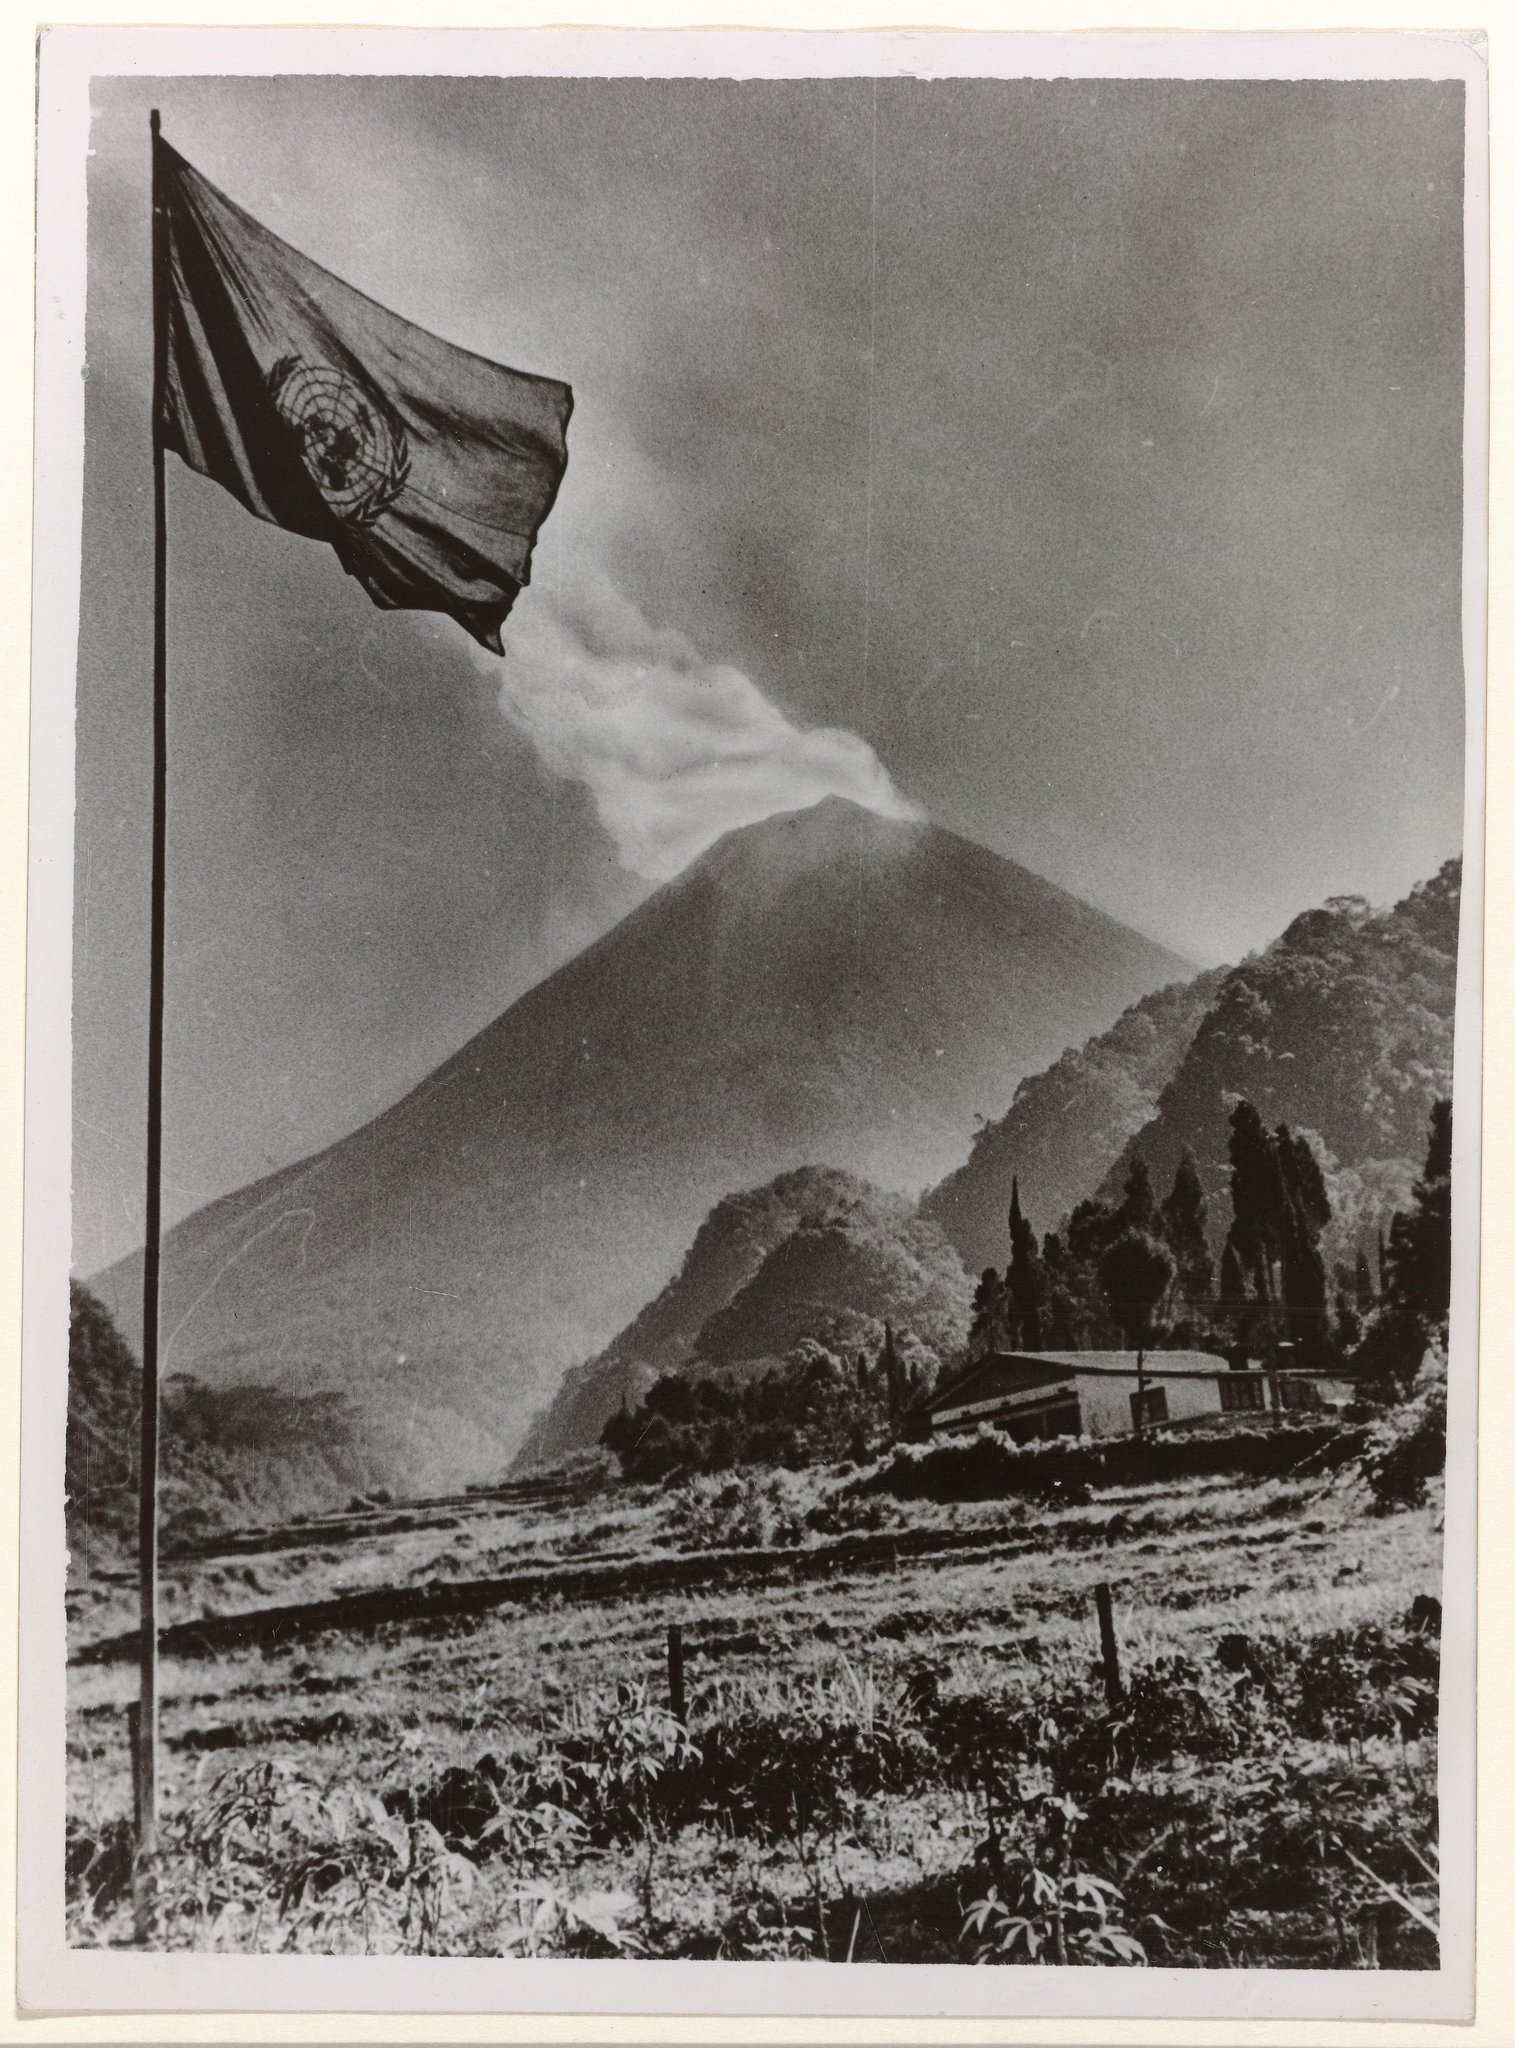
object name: photograph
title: Hoofdkwartier VN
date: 1950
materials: photographic support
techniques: photography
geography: java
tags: united nations, landscapes in tropical and sub-tropical regions, java, indonesia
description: De vlag van de Verenigde Naties wappert voor het hoofdkwartier in de nieuwe Republiek Indonesië. Op de achtergrond de actieve vulkaan Merapi, 20 januari 1950.